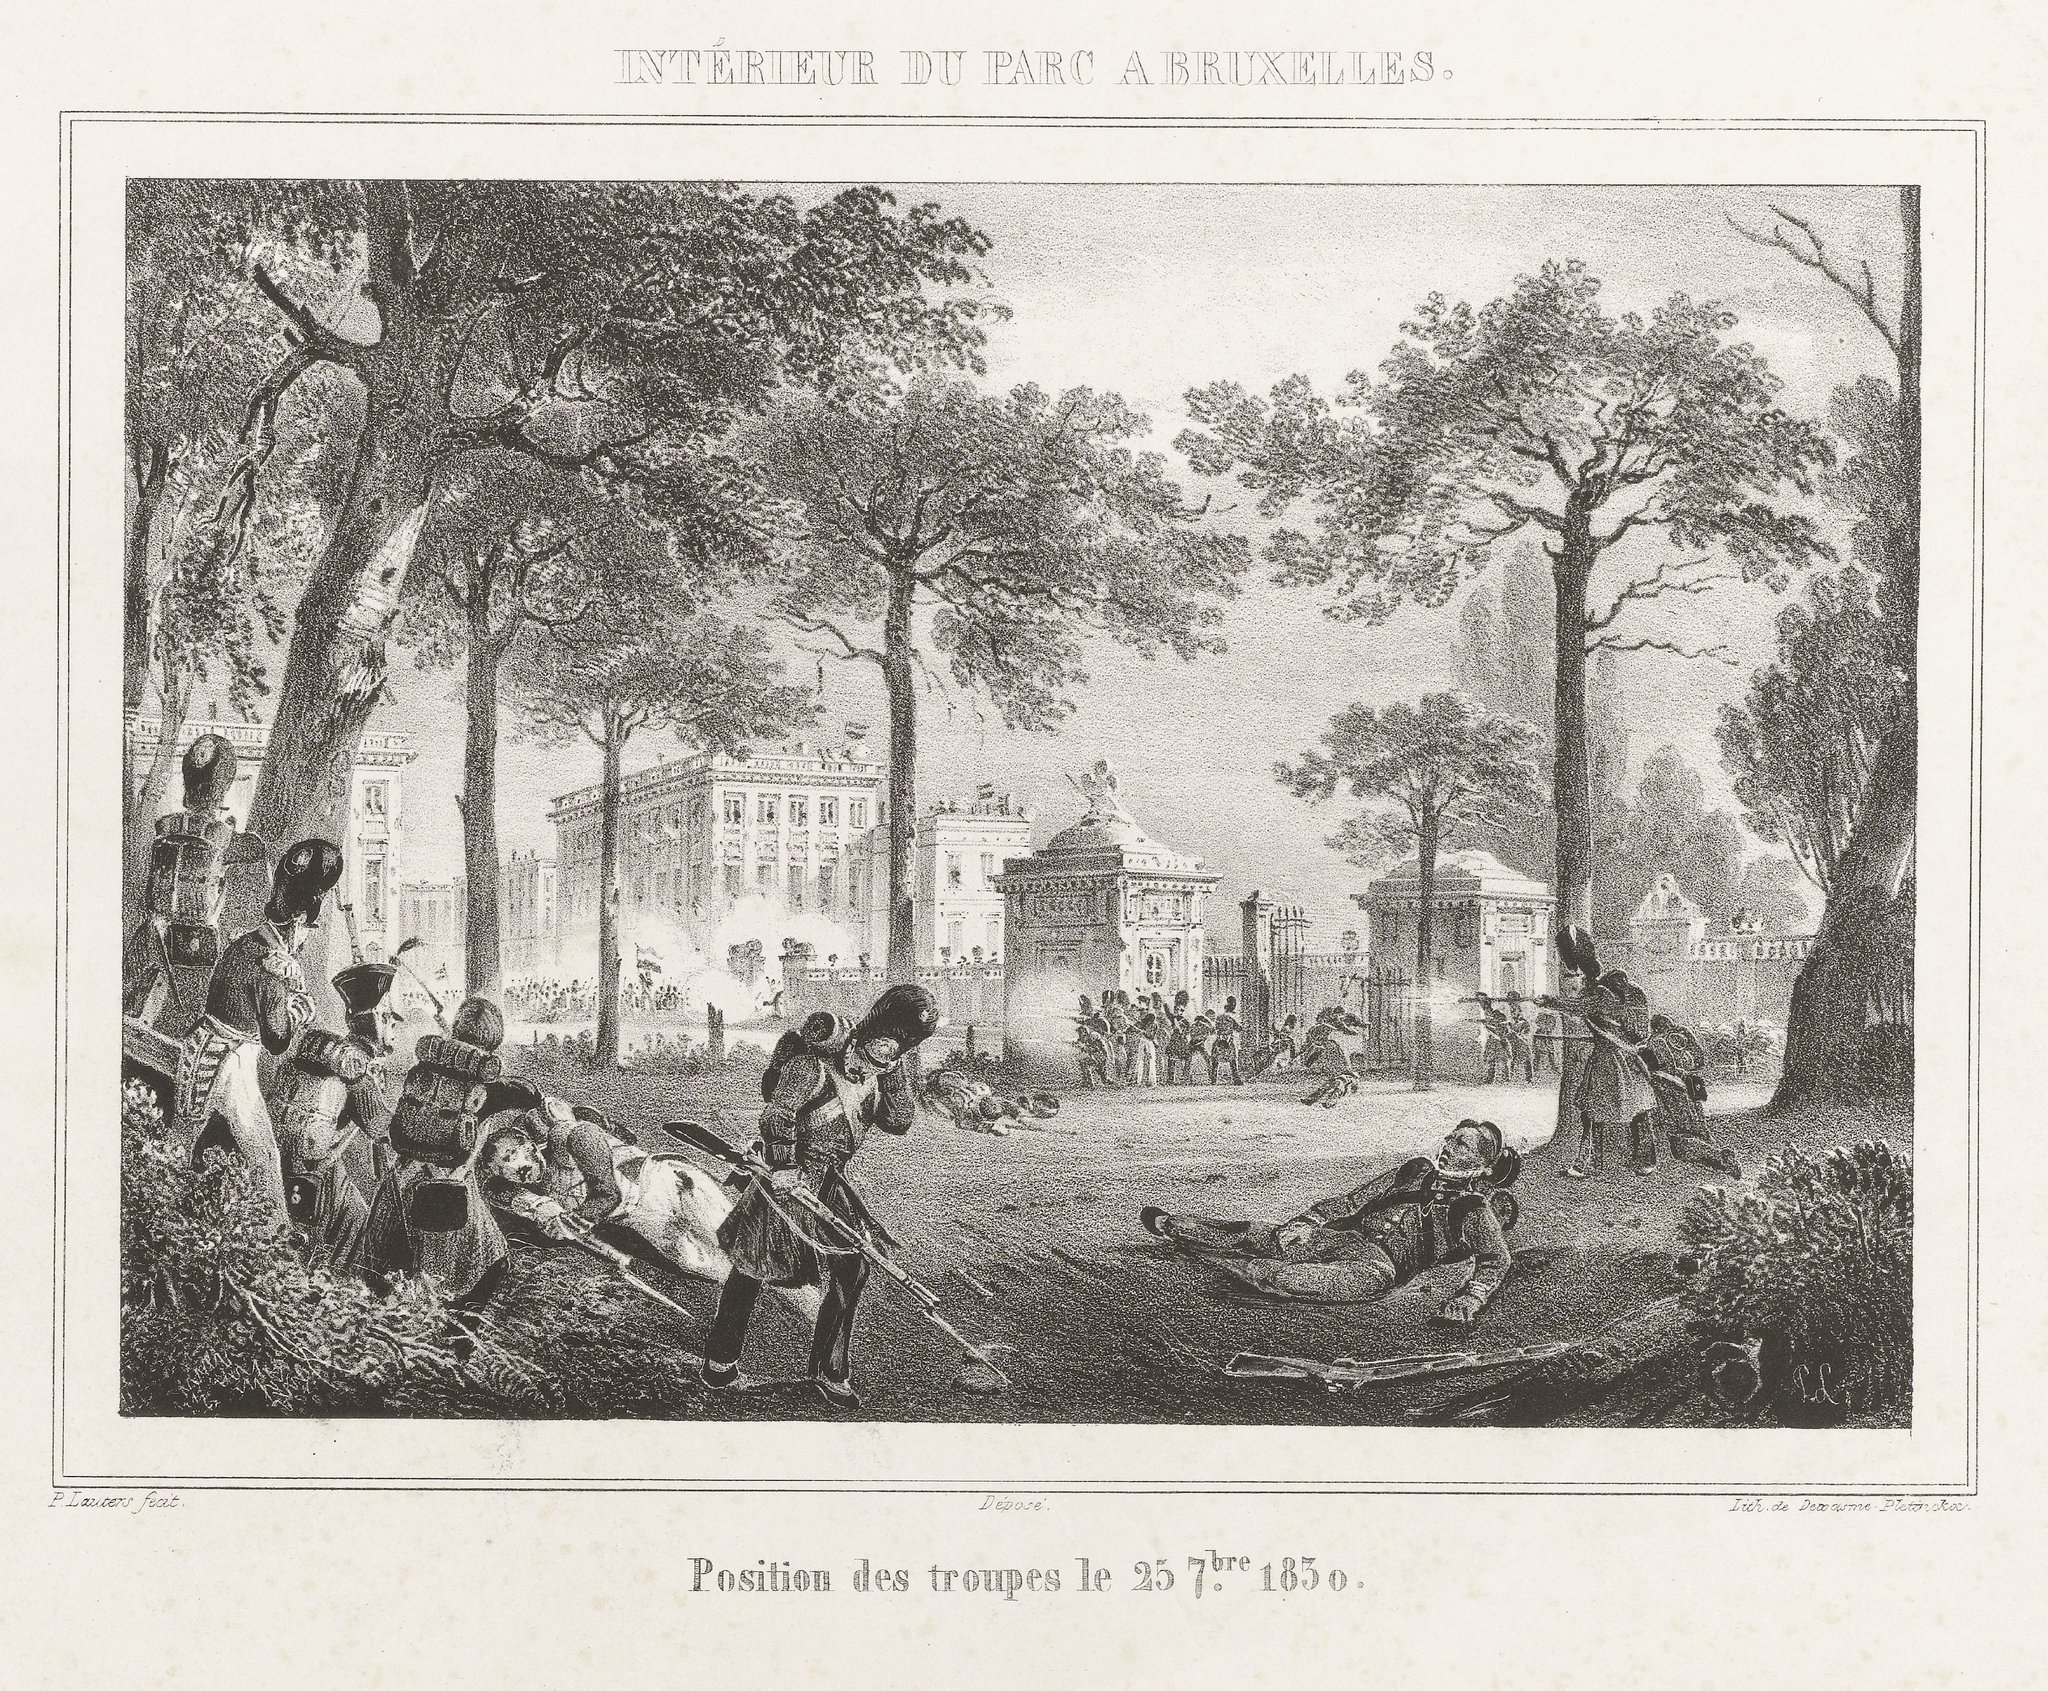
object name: print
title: Intérieur du parc a Bruxelles / Position des troupes le 25 7bre. 1830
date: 1830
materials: paper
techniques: lithograph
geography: brussels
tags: battle (+ land forces)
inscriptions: collector's mark: Lugt 2228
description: Gevechten bij het Koninklijk Paleis te Brussel, 25 september 1830. Onderdeel van een recueil met platen over de gebeurtenissen tijdens de Belgische Revolutie in Brussel, Antwerpen en andere steden in de periode 25 augustus 1830 tot 27 maart 1831.